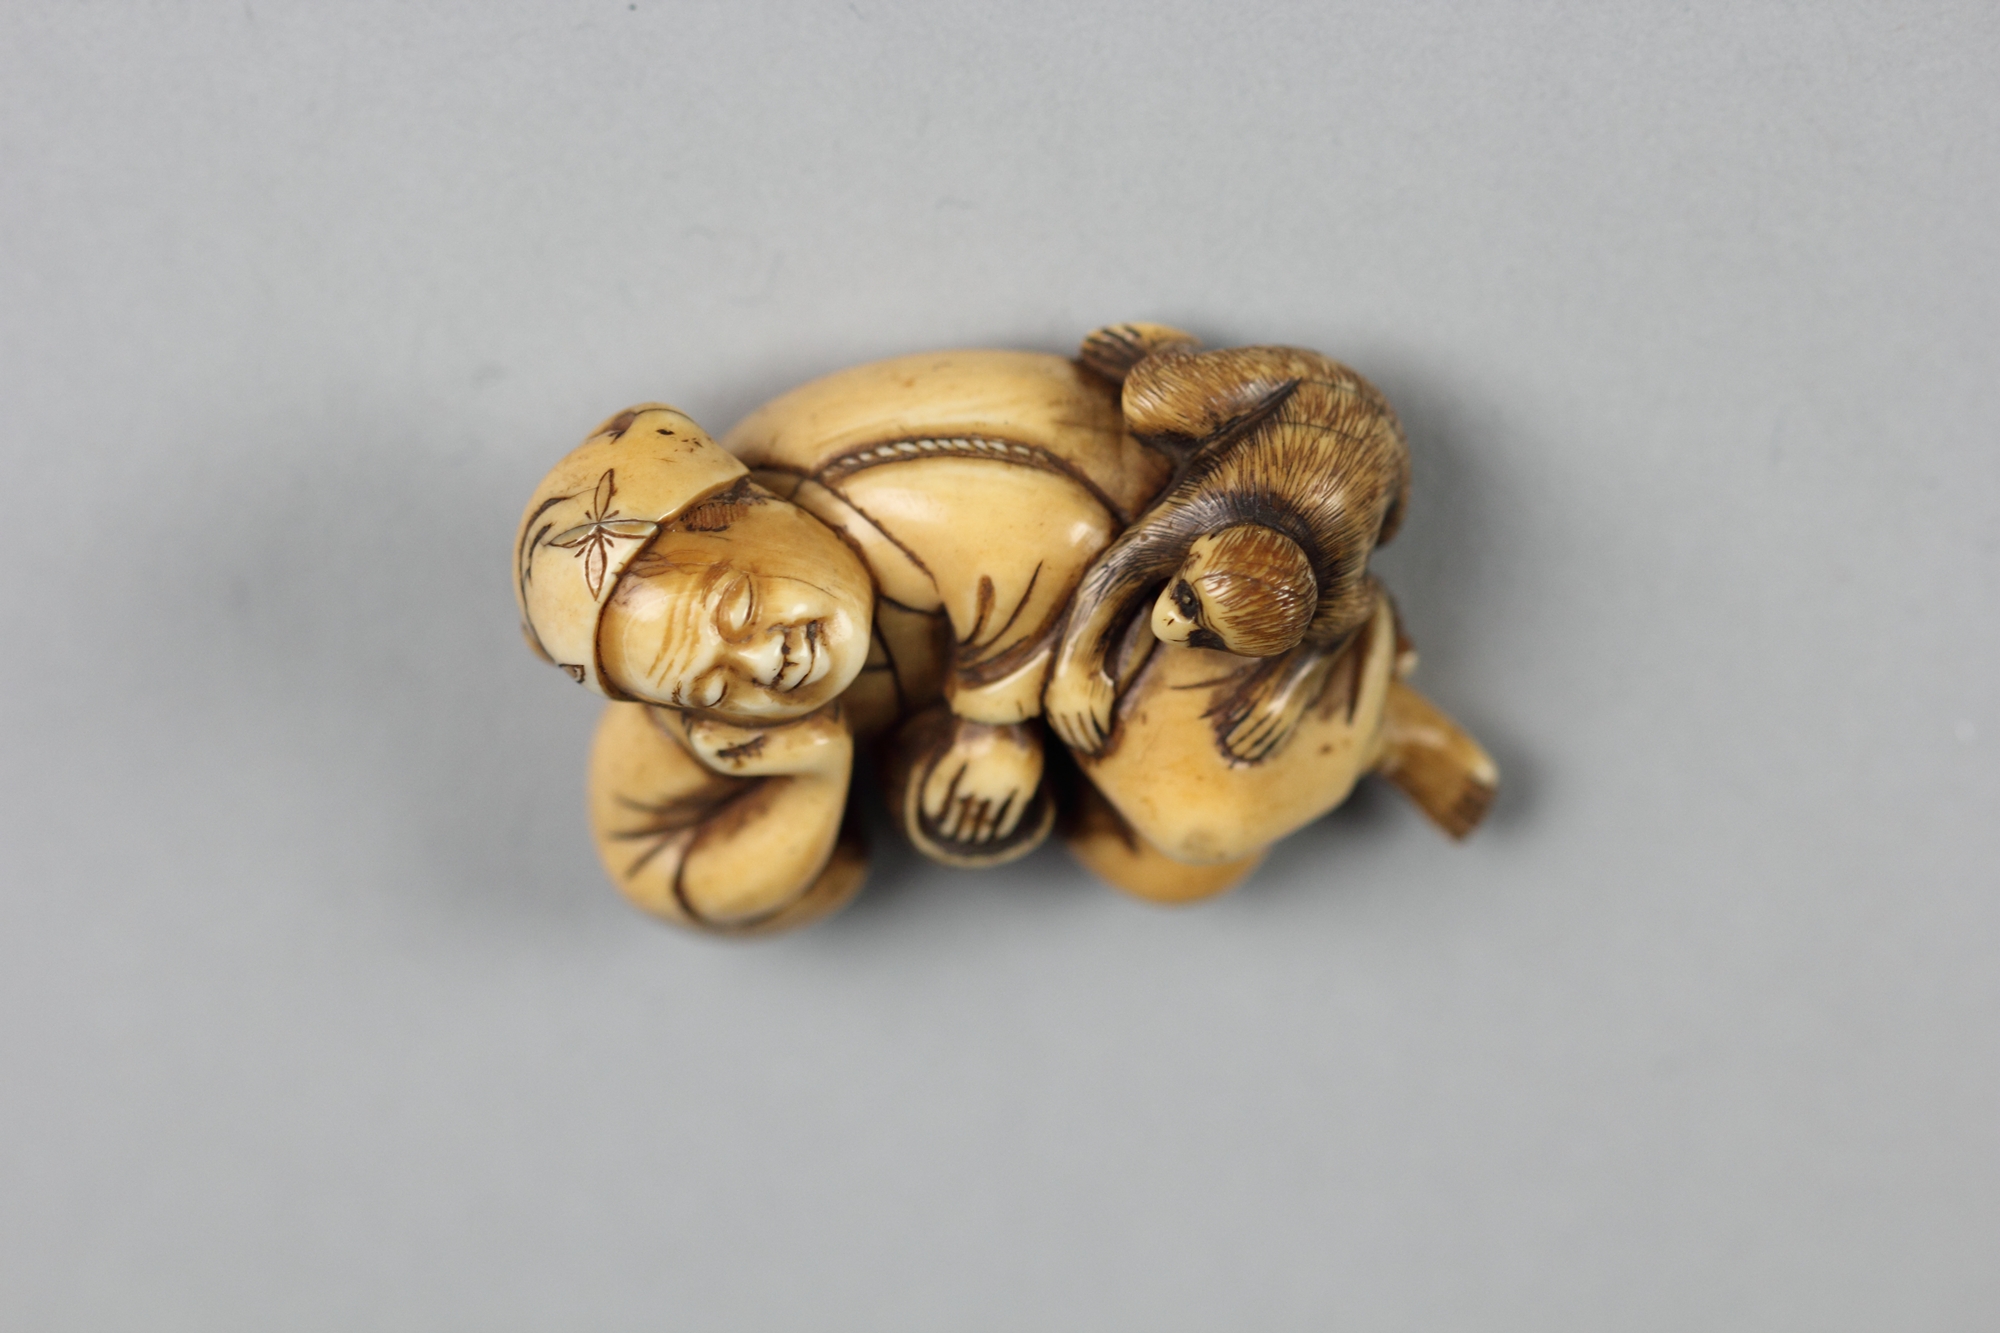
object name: netsuke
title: Netsuke of Sleeping Man and a Monkey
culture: japanese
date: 1801-1900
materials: ivory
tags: men,monkeys